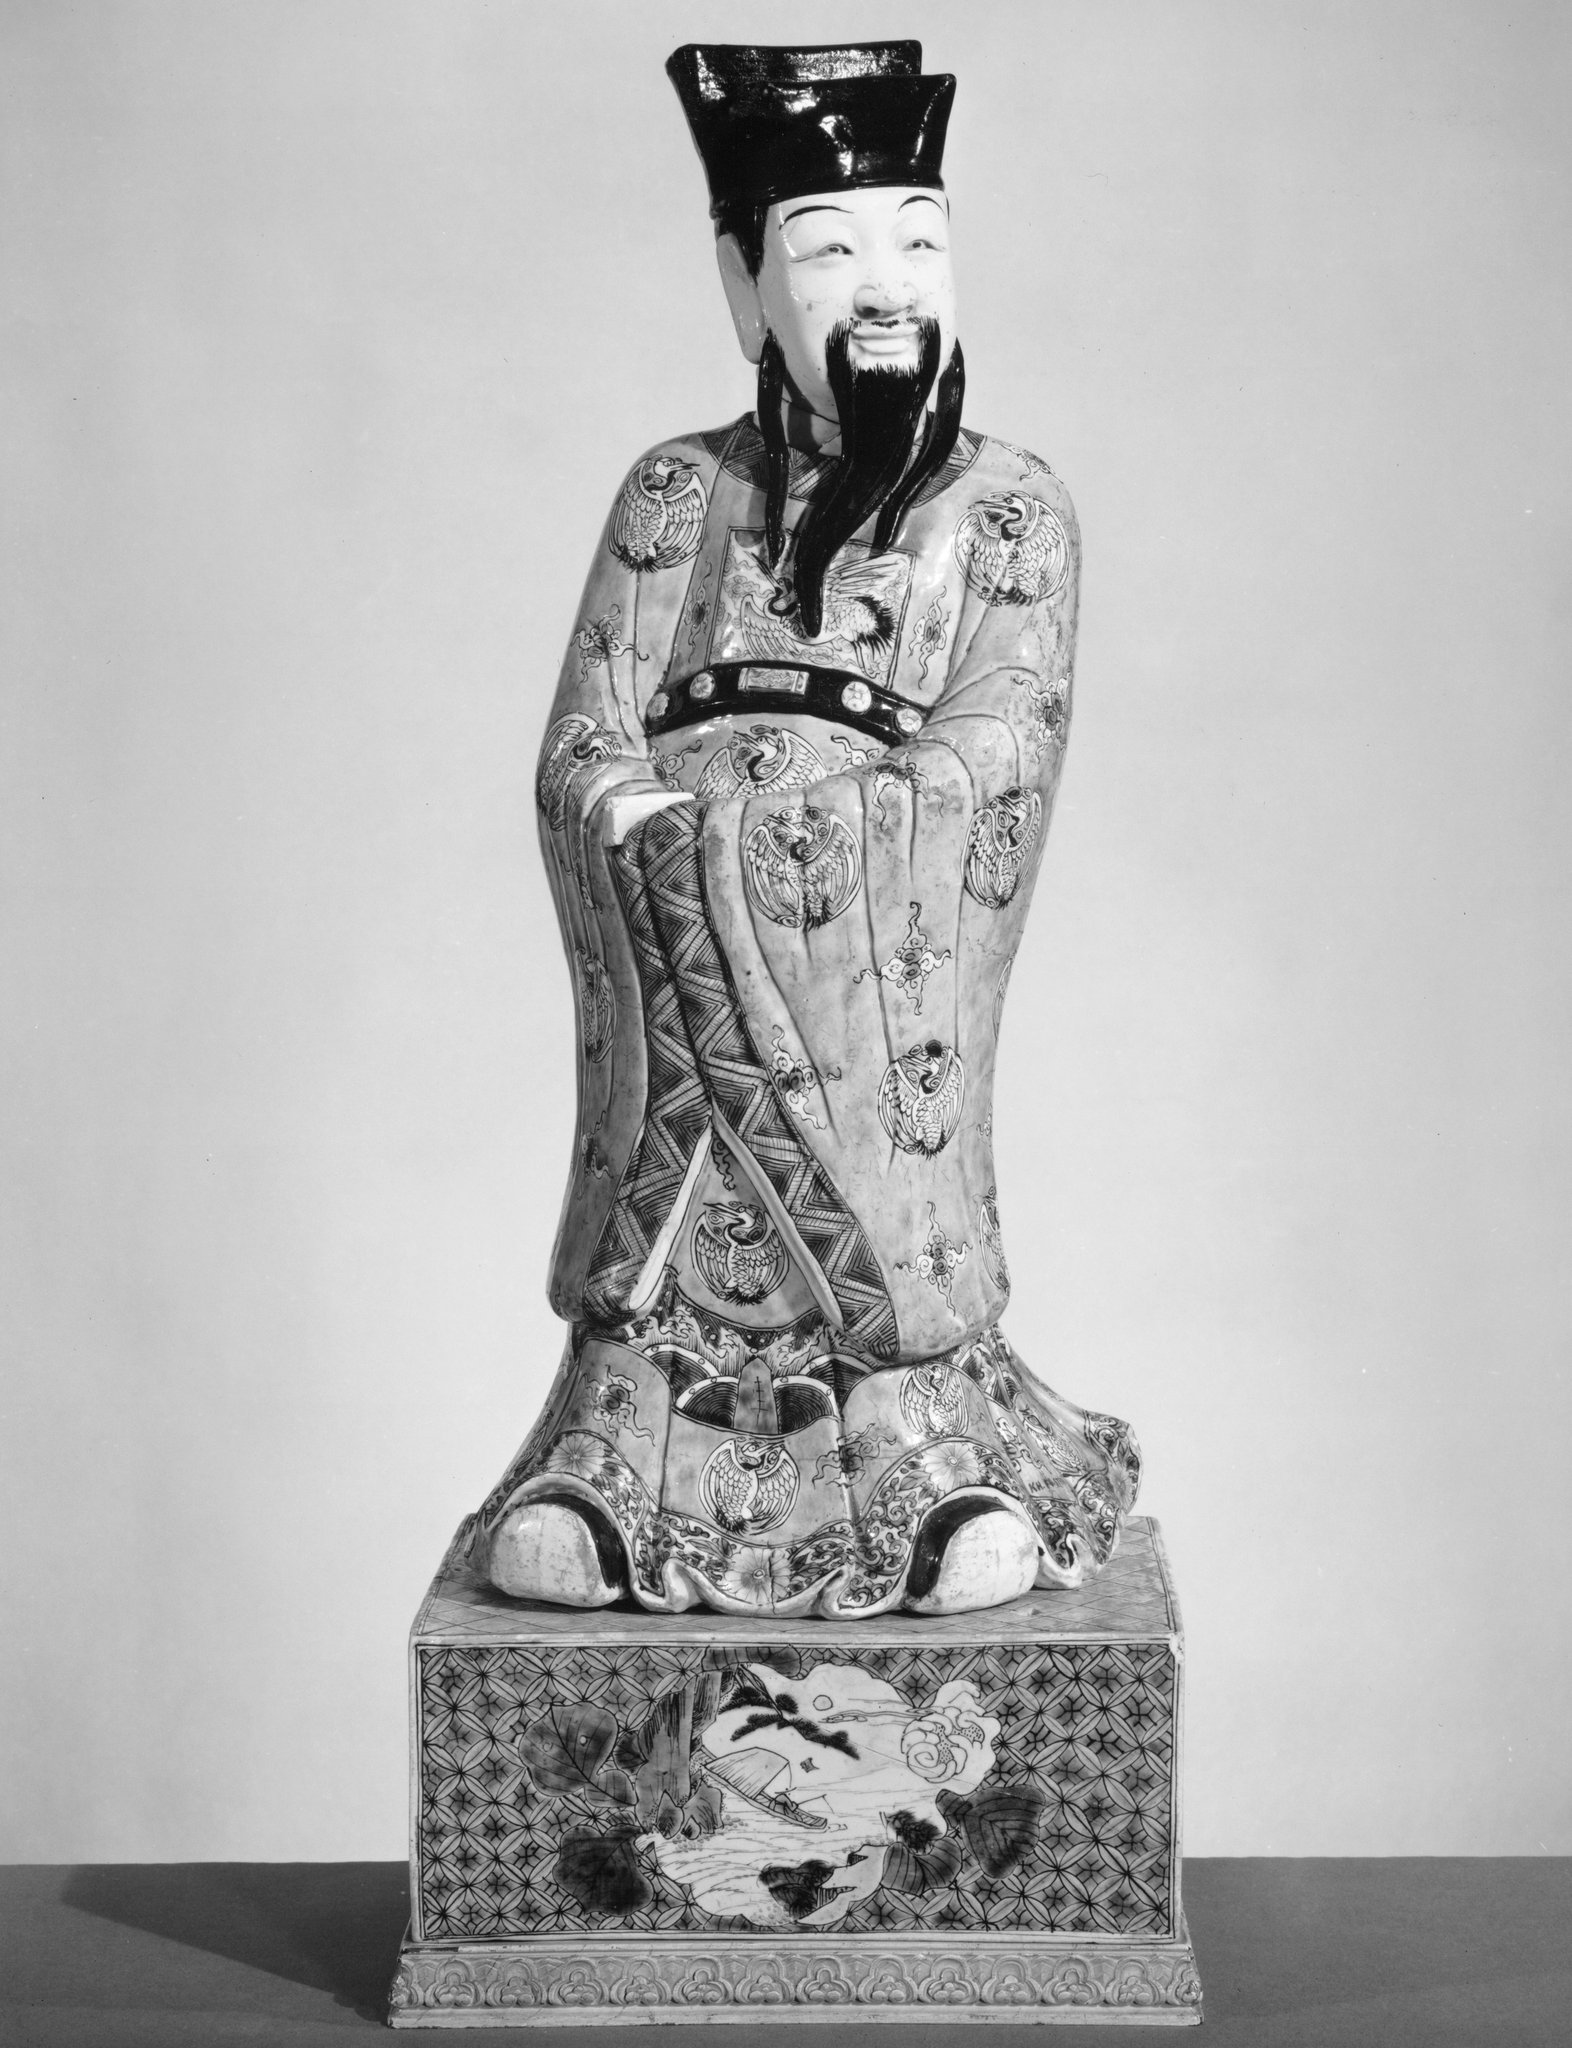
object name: figure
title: Standing Taoist God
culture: chinese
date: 1667-1733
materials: biscuit, porcelain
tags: daoism